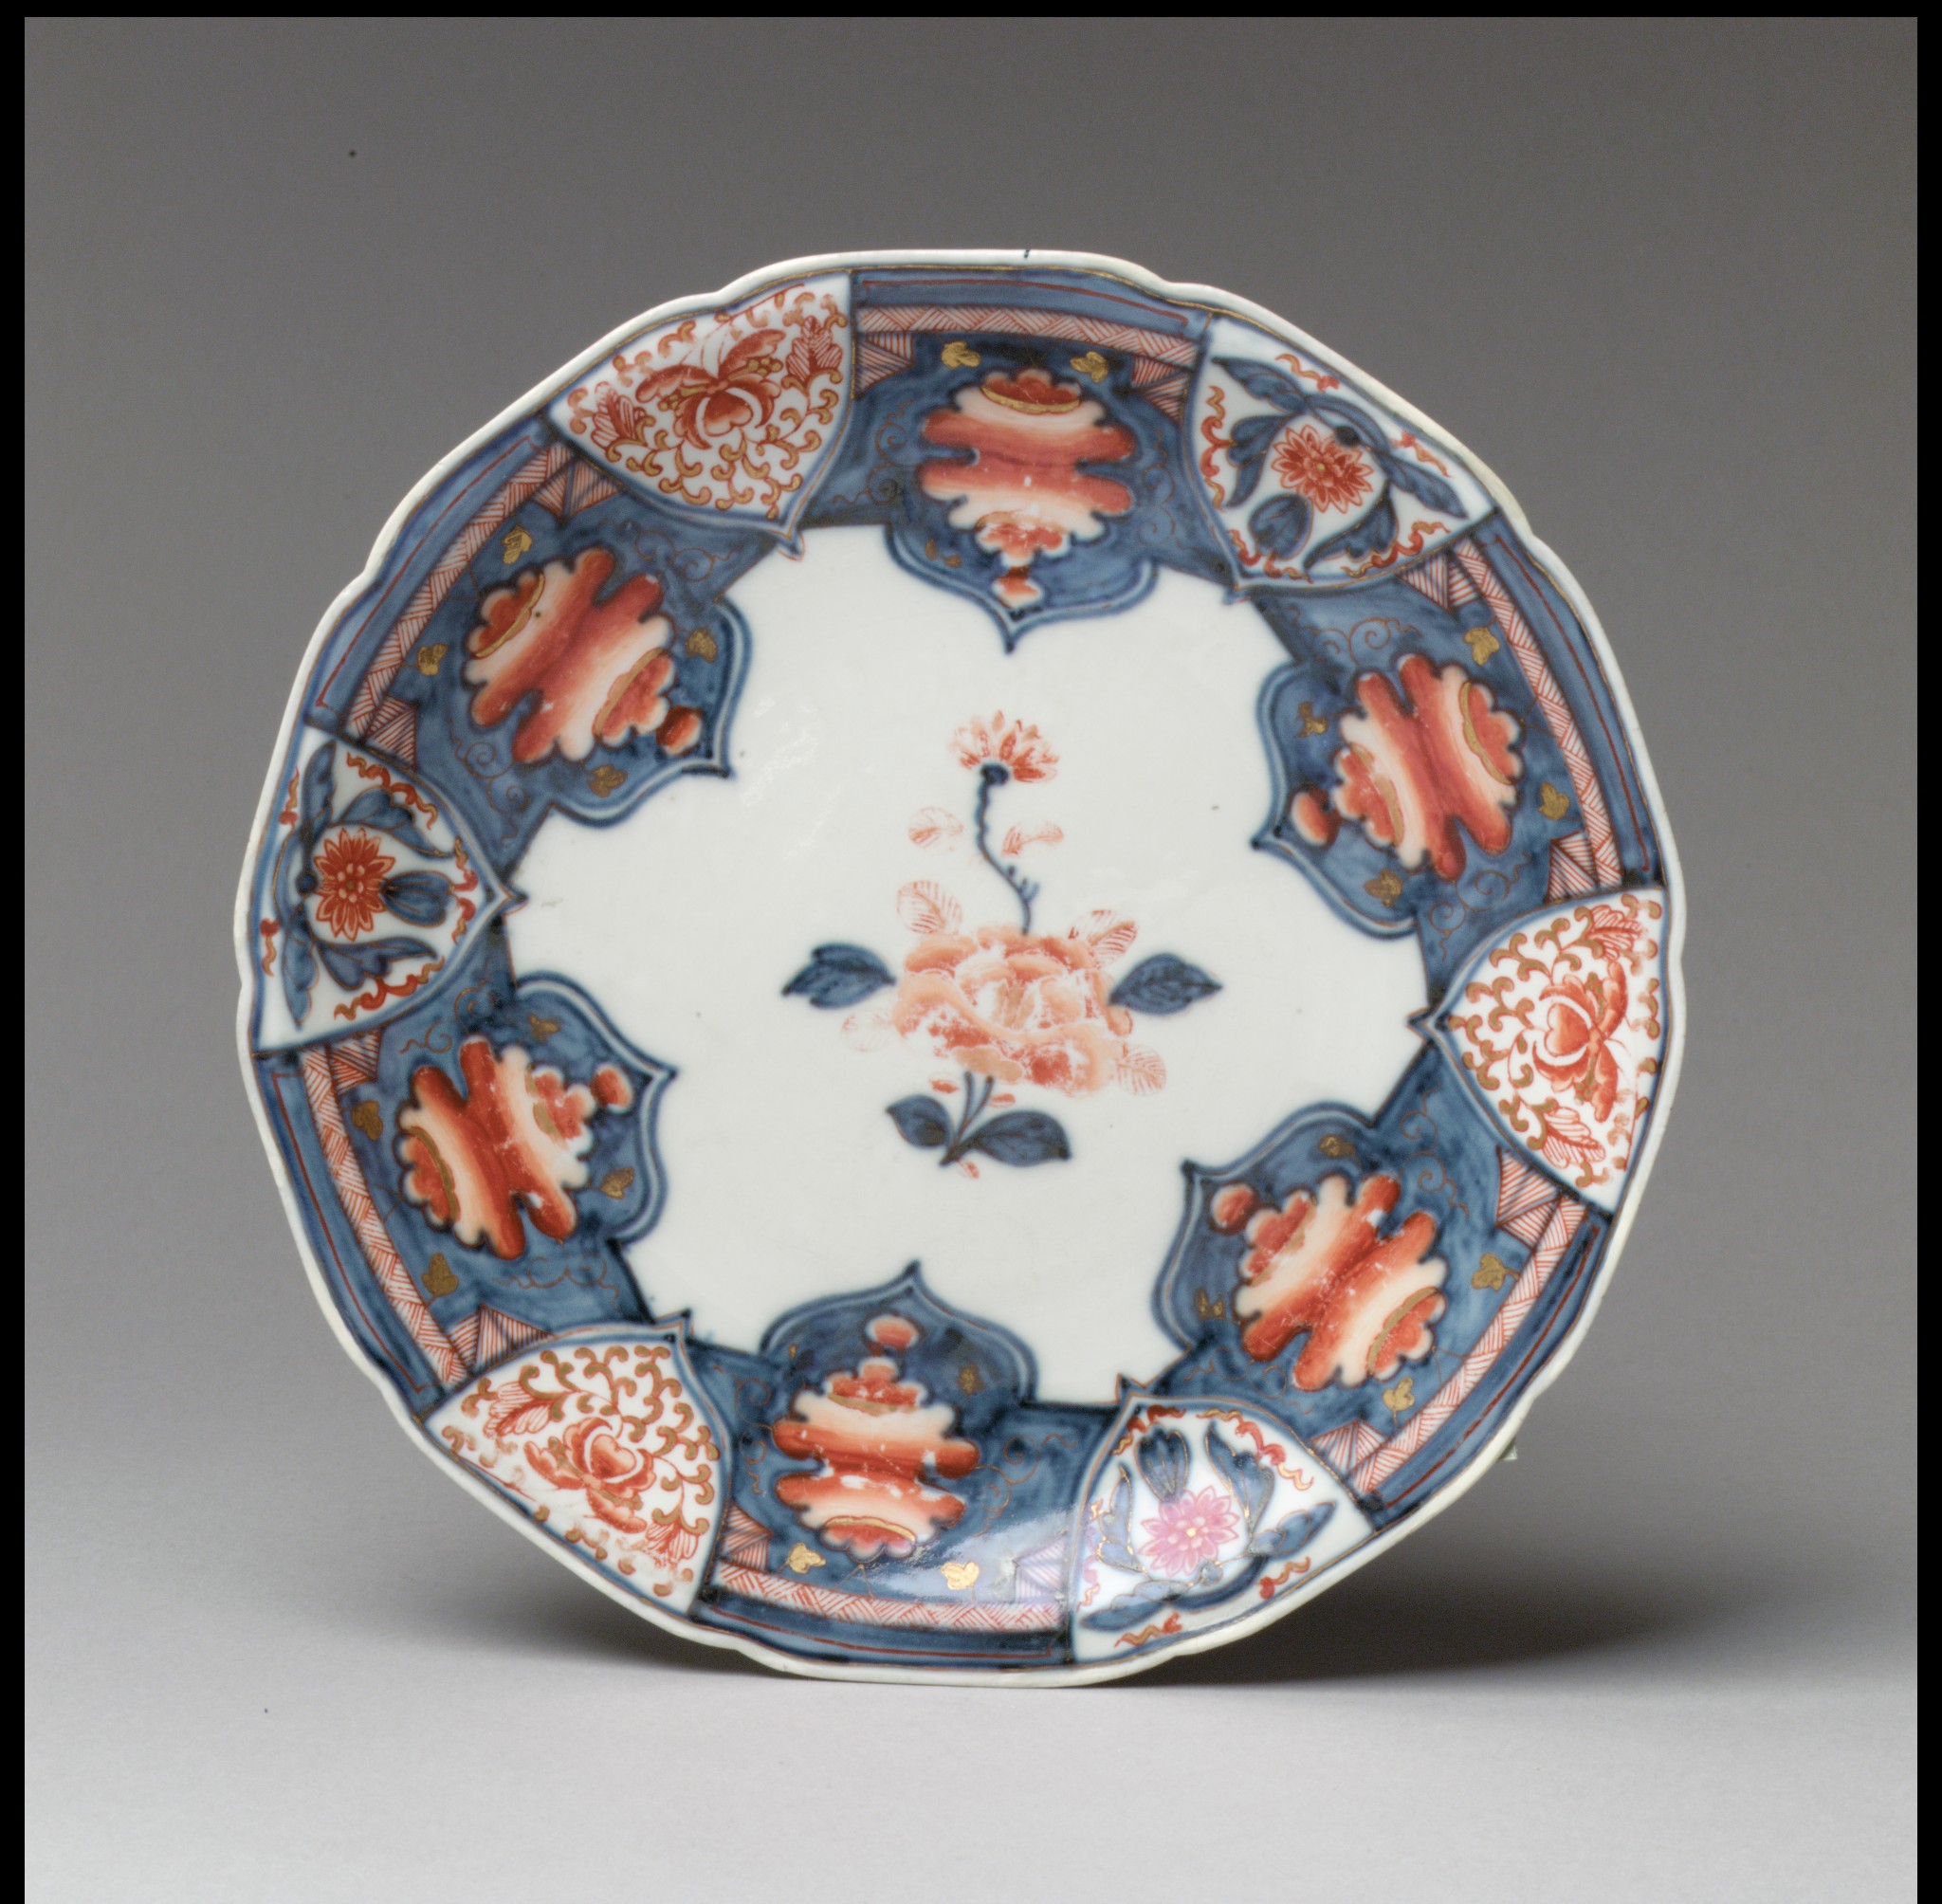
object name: plate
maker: imperial porcelain manufactory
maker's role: manufactory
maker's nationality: austrian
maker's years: 1744-1864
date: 1750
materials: hard paste porcelain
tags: flowers